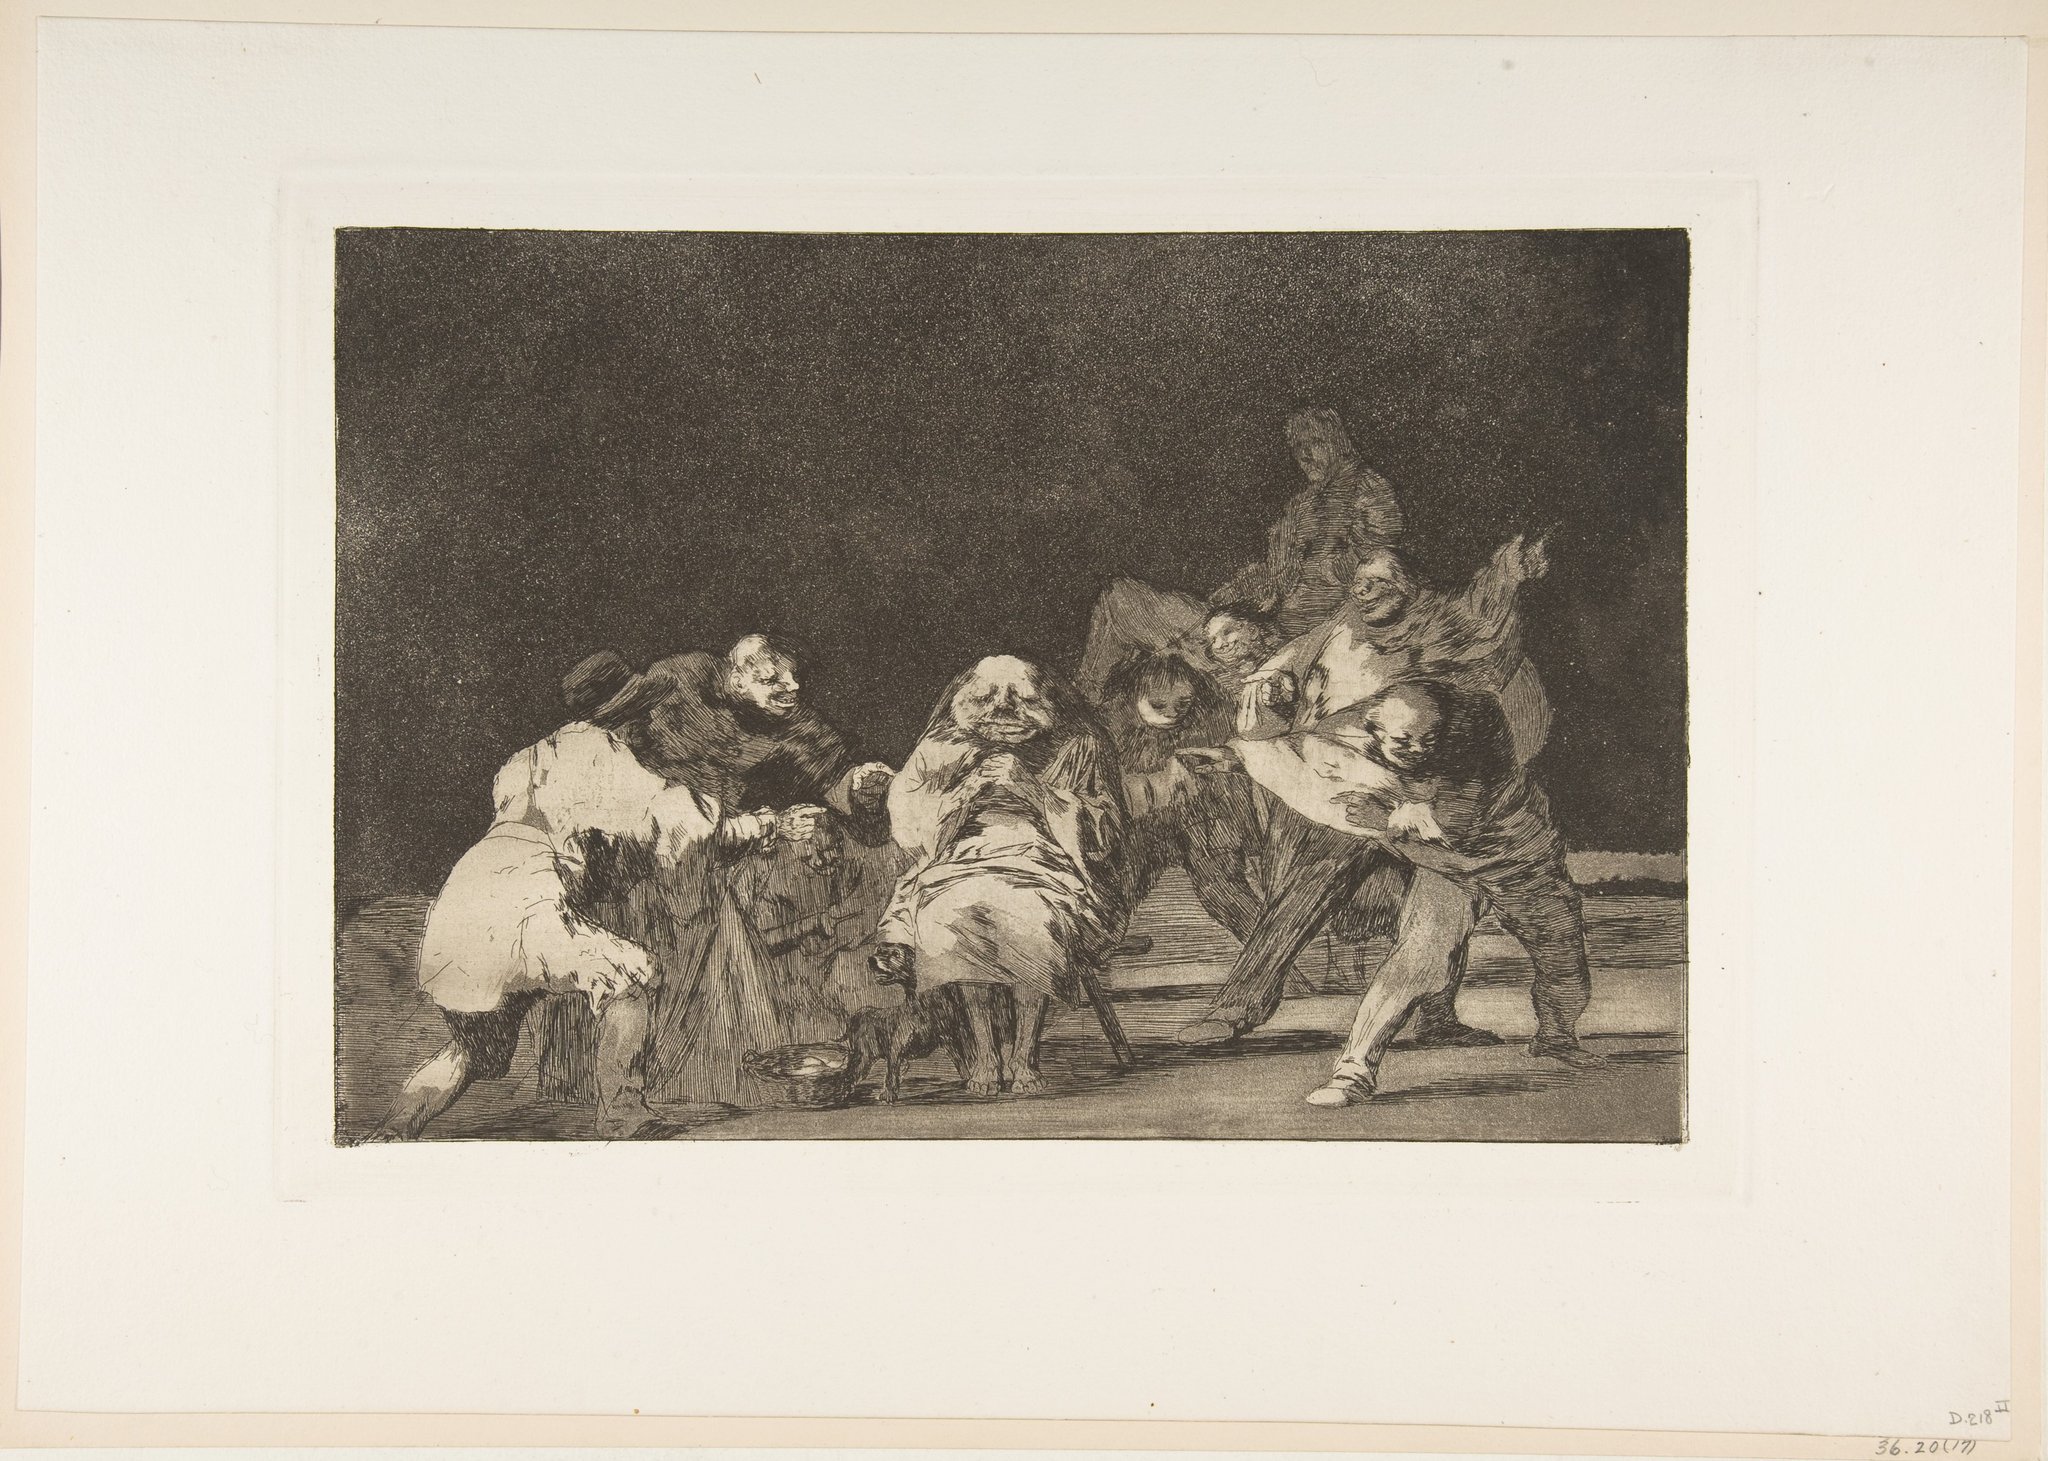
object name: print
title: 'Loyalty' from the 'Disparates' (Follies / Irrationalities)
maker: goya (francisco de goya y lucientes)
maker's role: artist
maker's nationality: spanish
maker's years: 1746-1828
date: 1815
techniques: aquatint, burnishing, etching